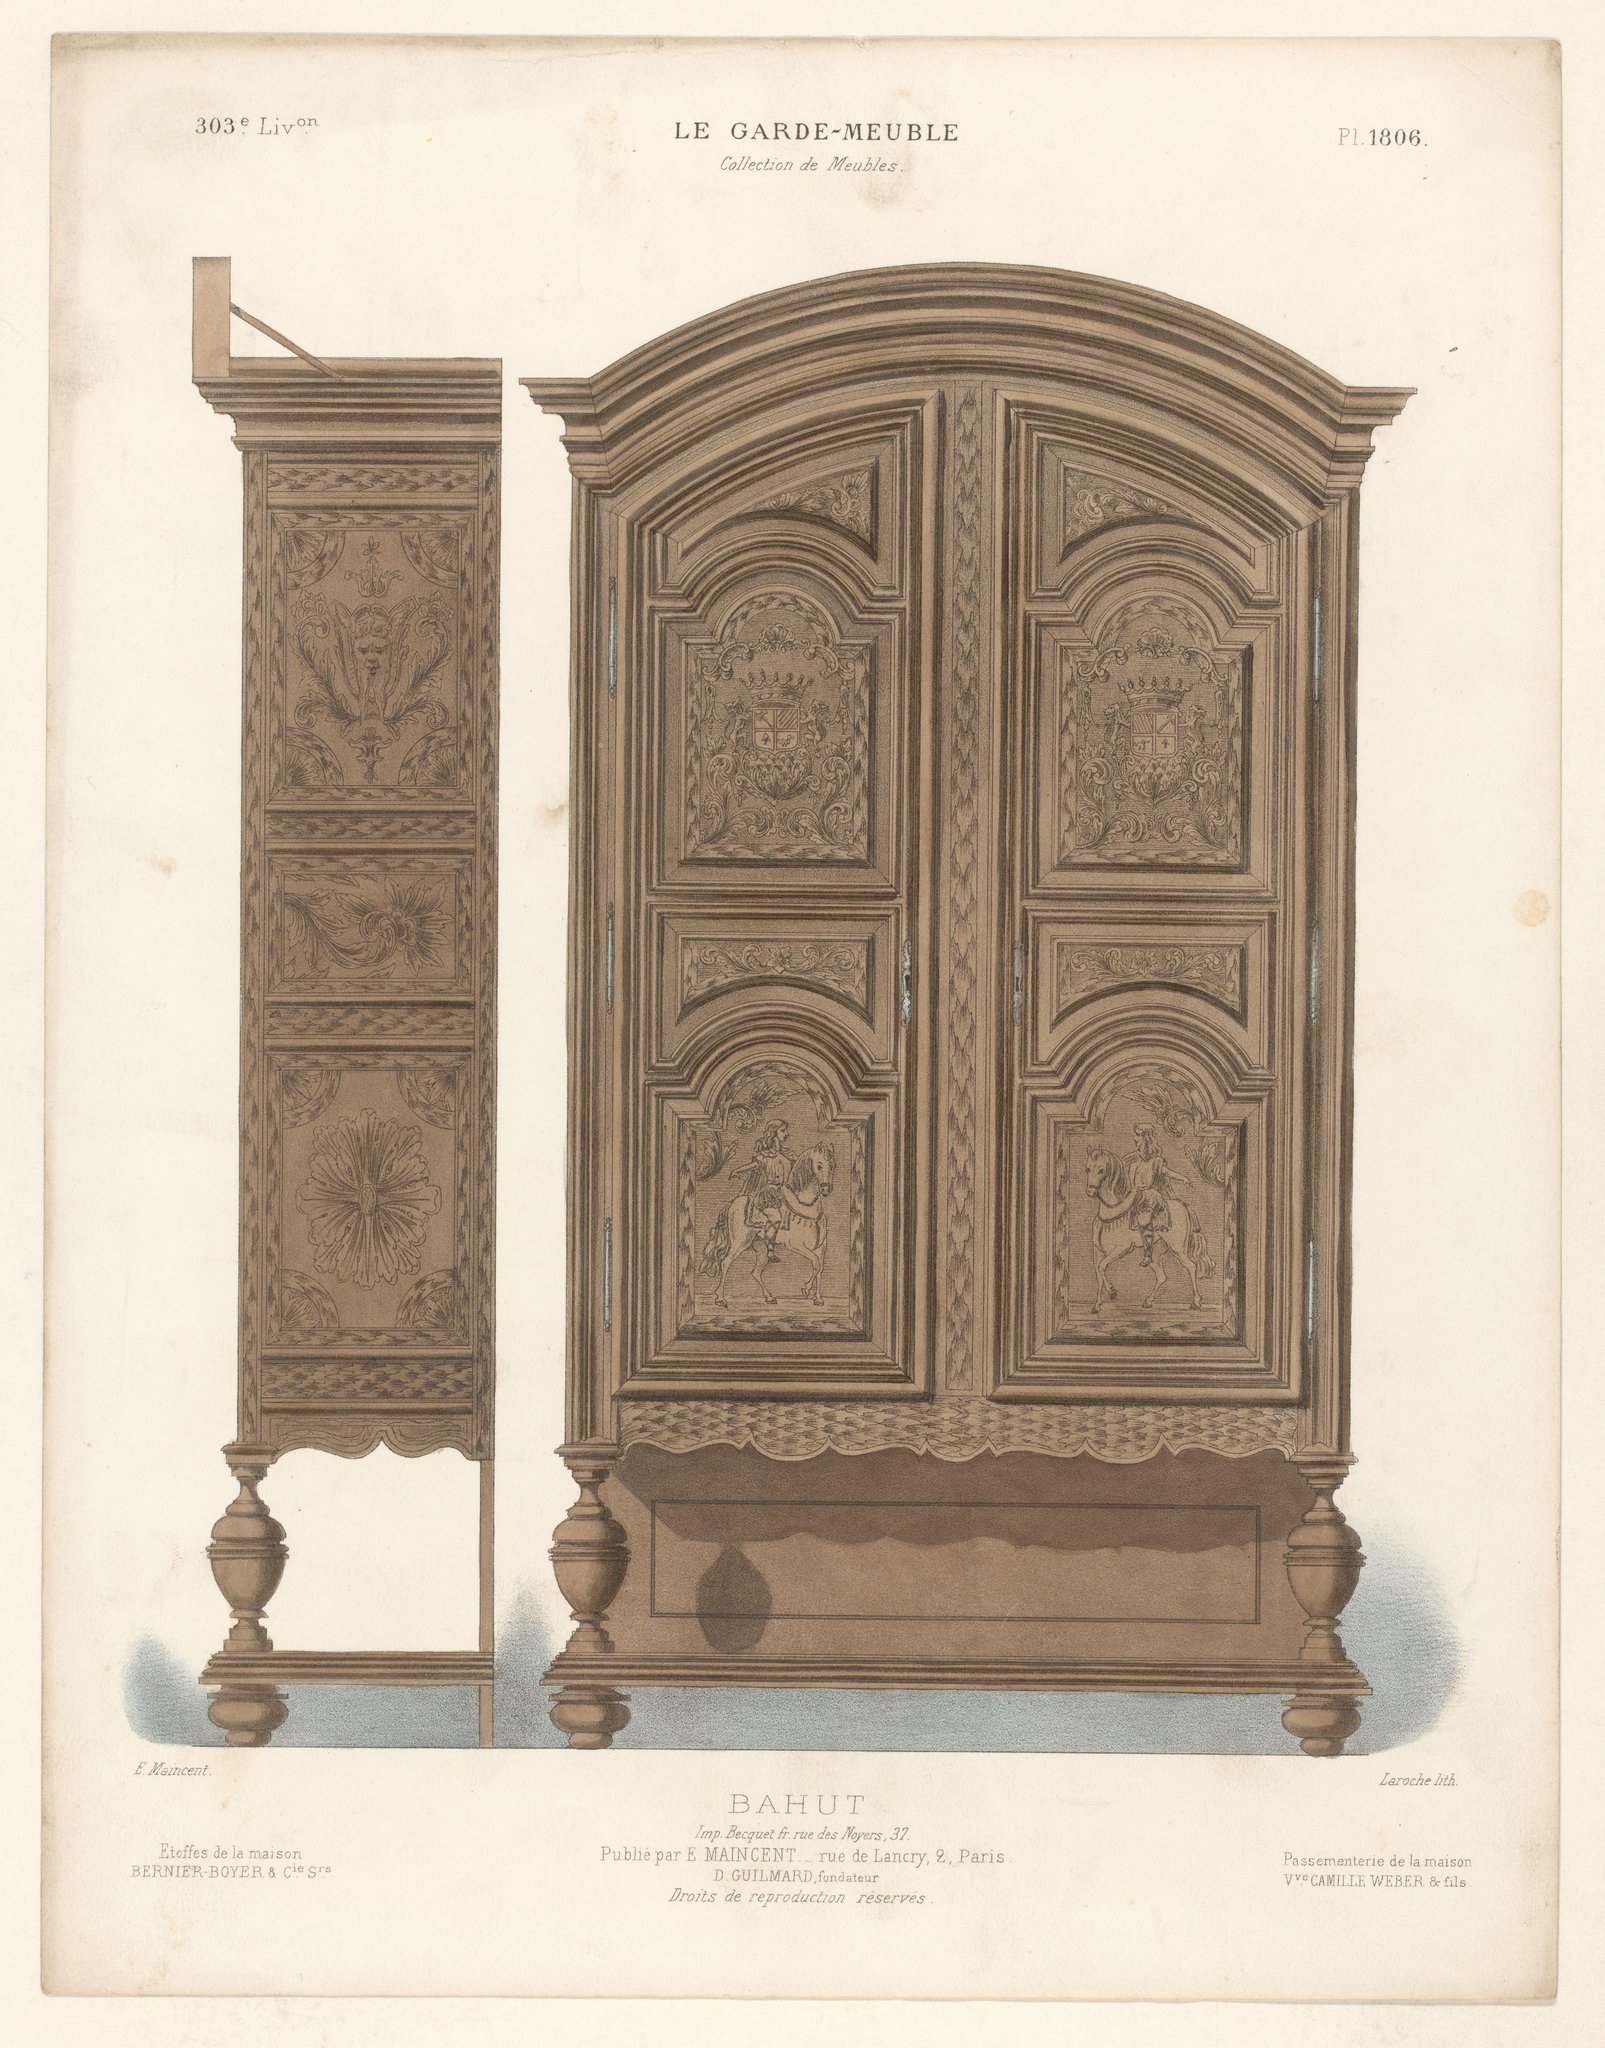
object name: print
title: Bahut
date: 1885-1895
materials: paper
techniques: hand coloring, lithograph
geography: paris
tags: furniture for storage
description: Ieder Livraison in de serie Le Garde-Meuble bevat negen platen: drie 'sièges' (zitmeubels), drie 'meubles' (diverse meubels zoals tafels en kasten) en drie 'tentures' (gordijnen en draperieën).